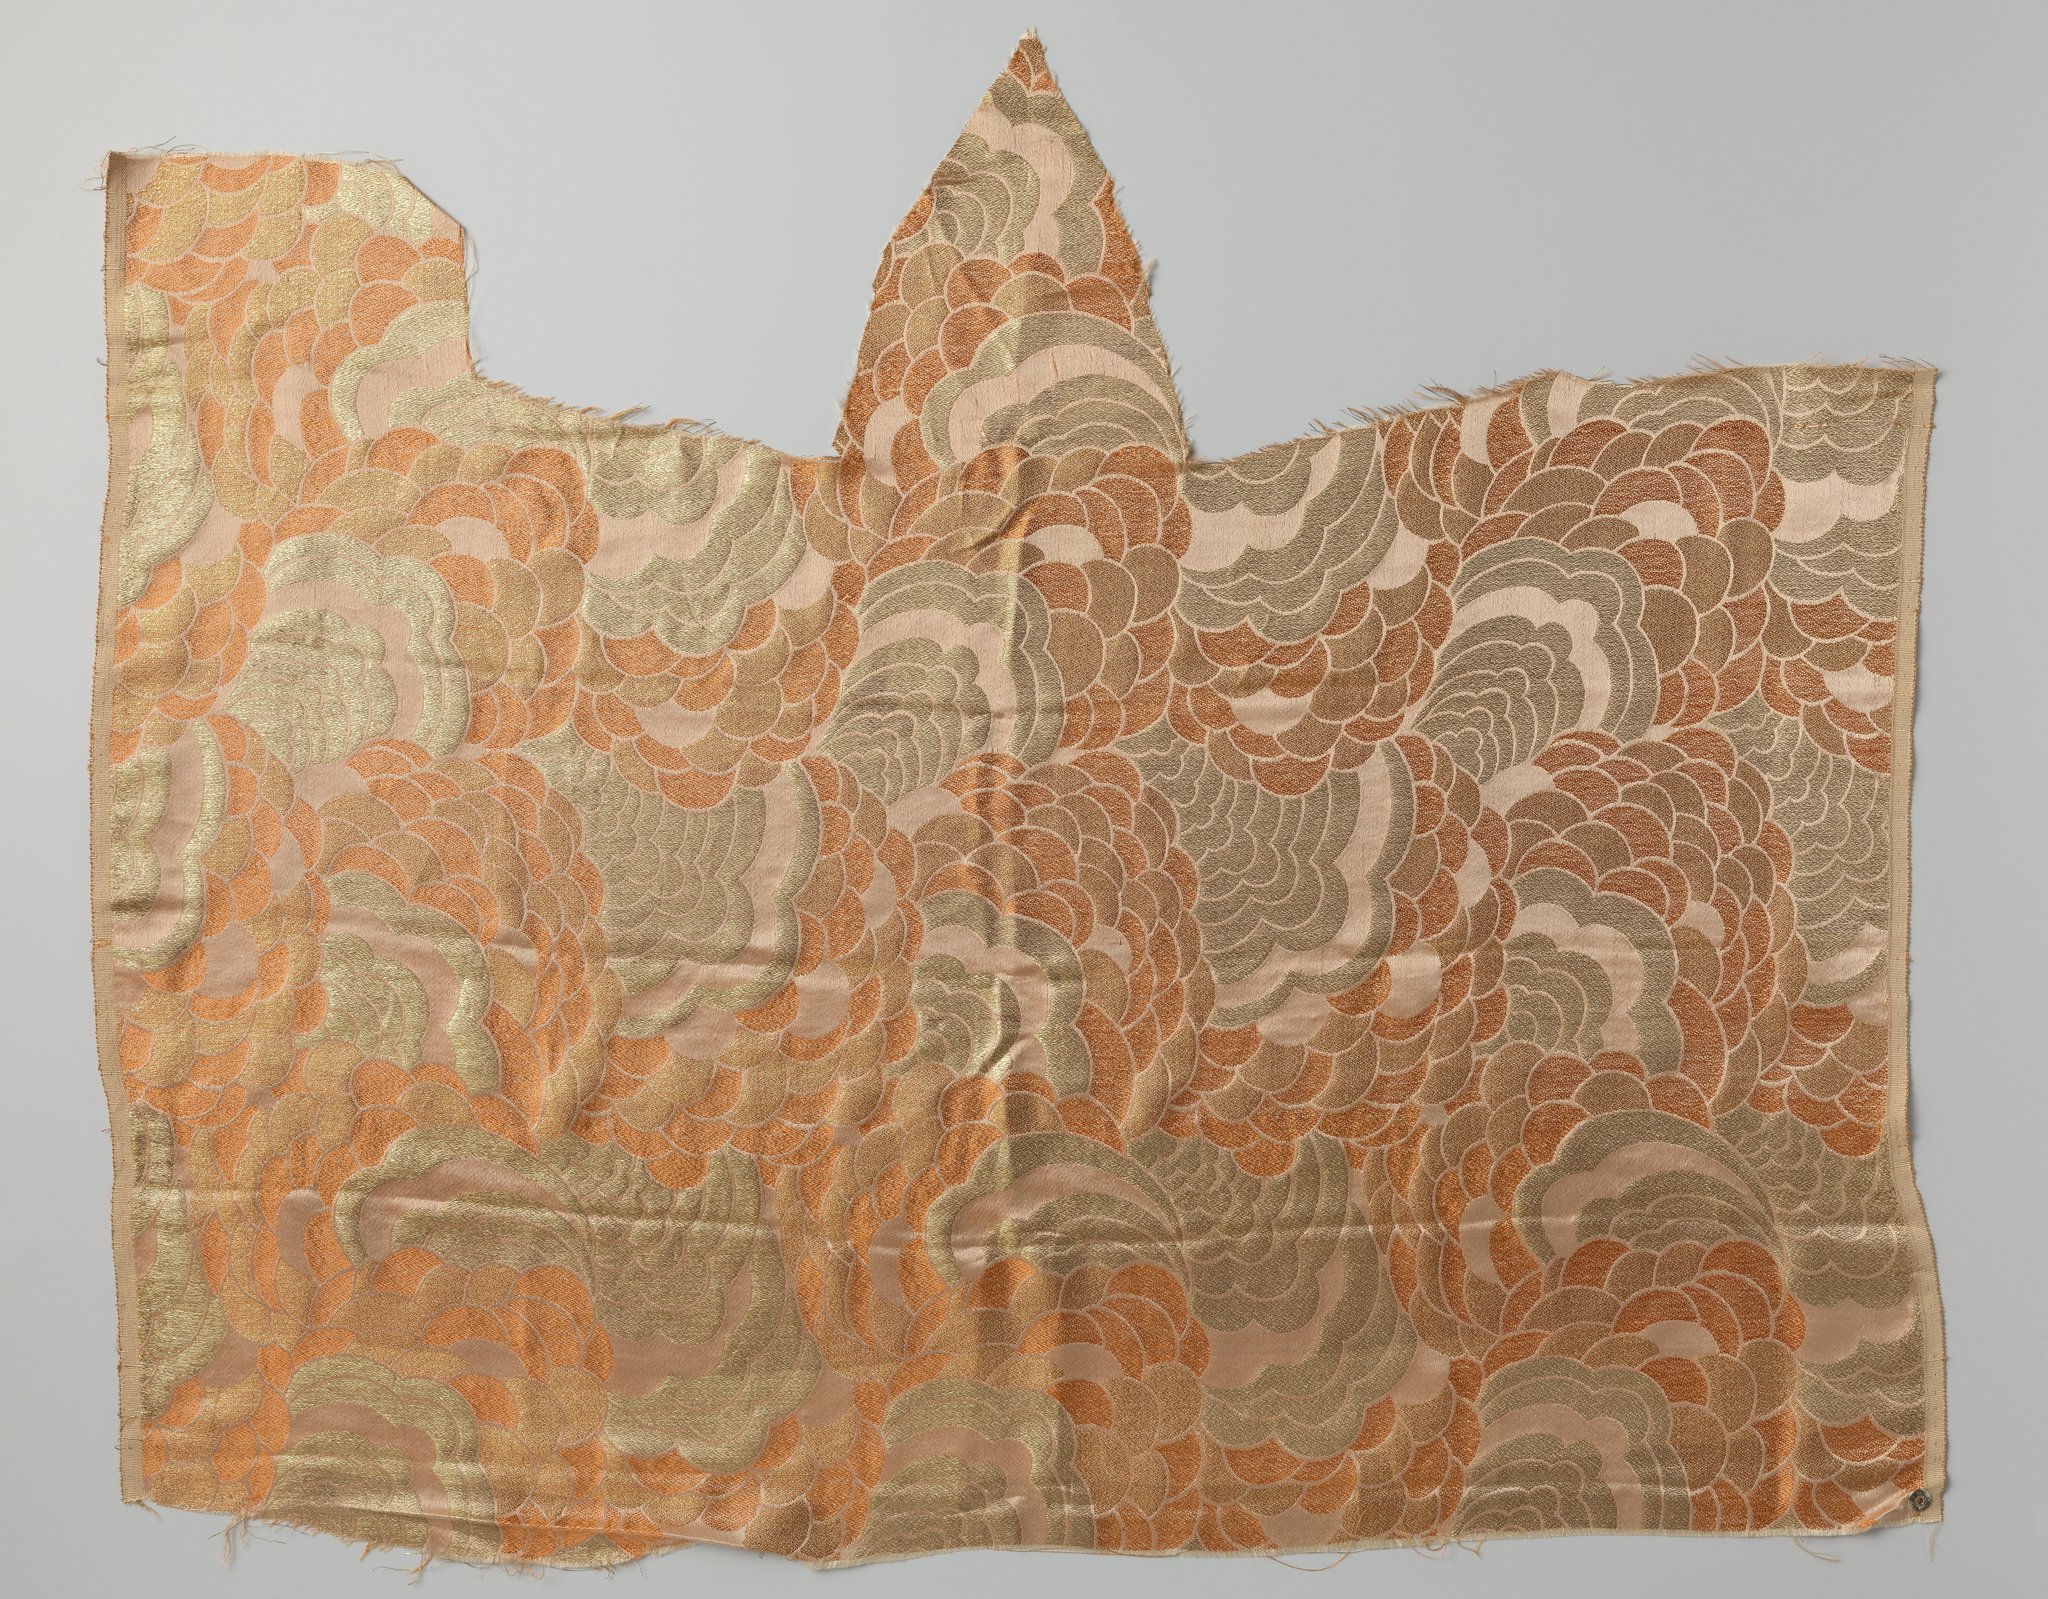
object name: satijnbrokaat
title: Fragment of lap zijden brokaat met wolkenmotieven in goud tegen een achtergrond van twee schakeringen zalmkleur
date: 1920-1930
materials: silk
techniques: brocade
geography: lyon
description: Fragment of lap zijden brokaat met wolkenmotieven in goud tegen een achtergrond van twee schakeringen zalmkleur. Lyon, in of voor 1924.